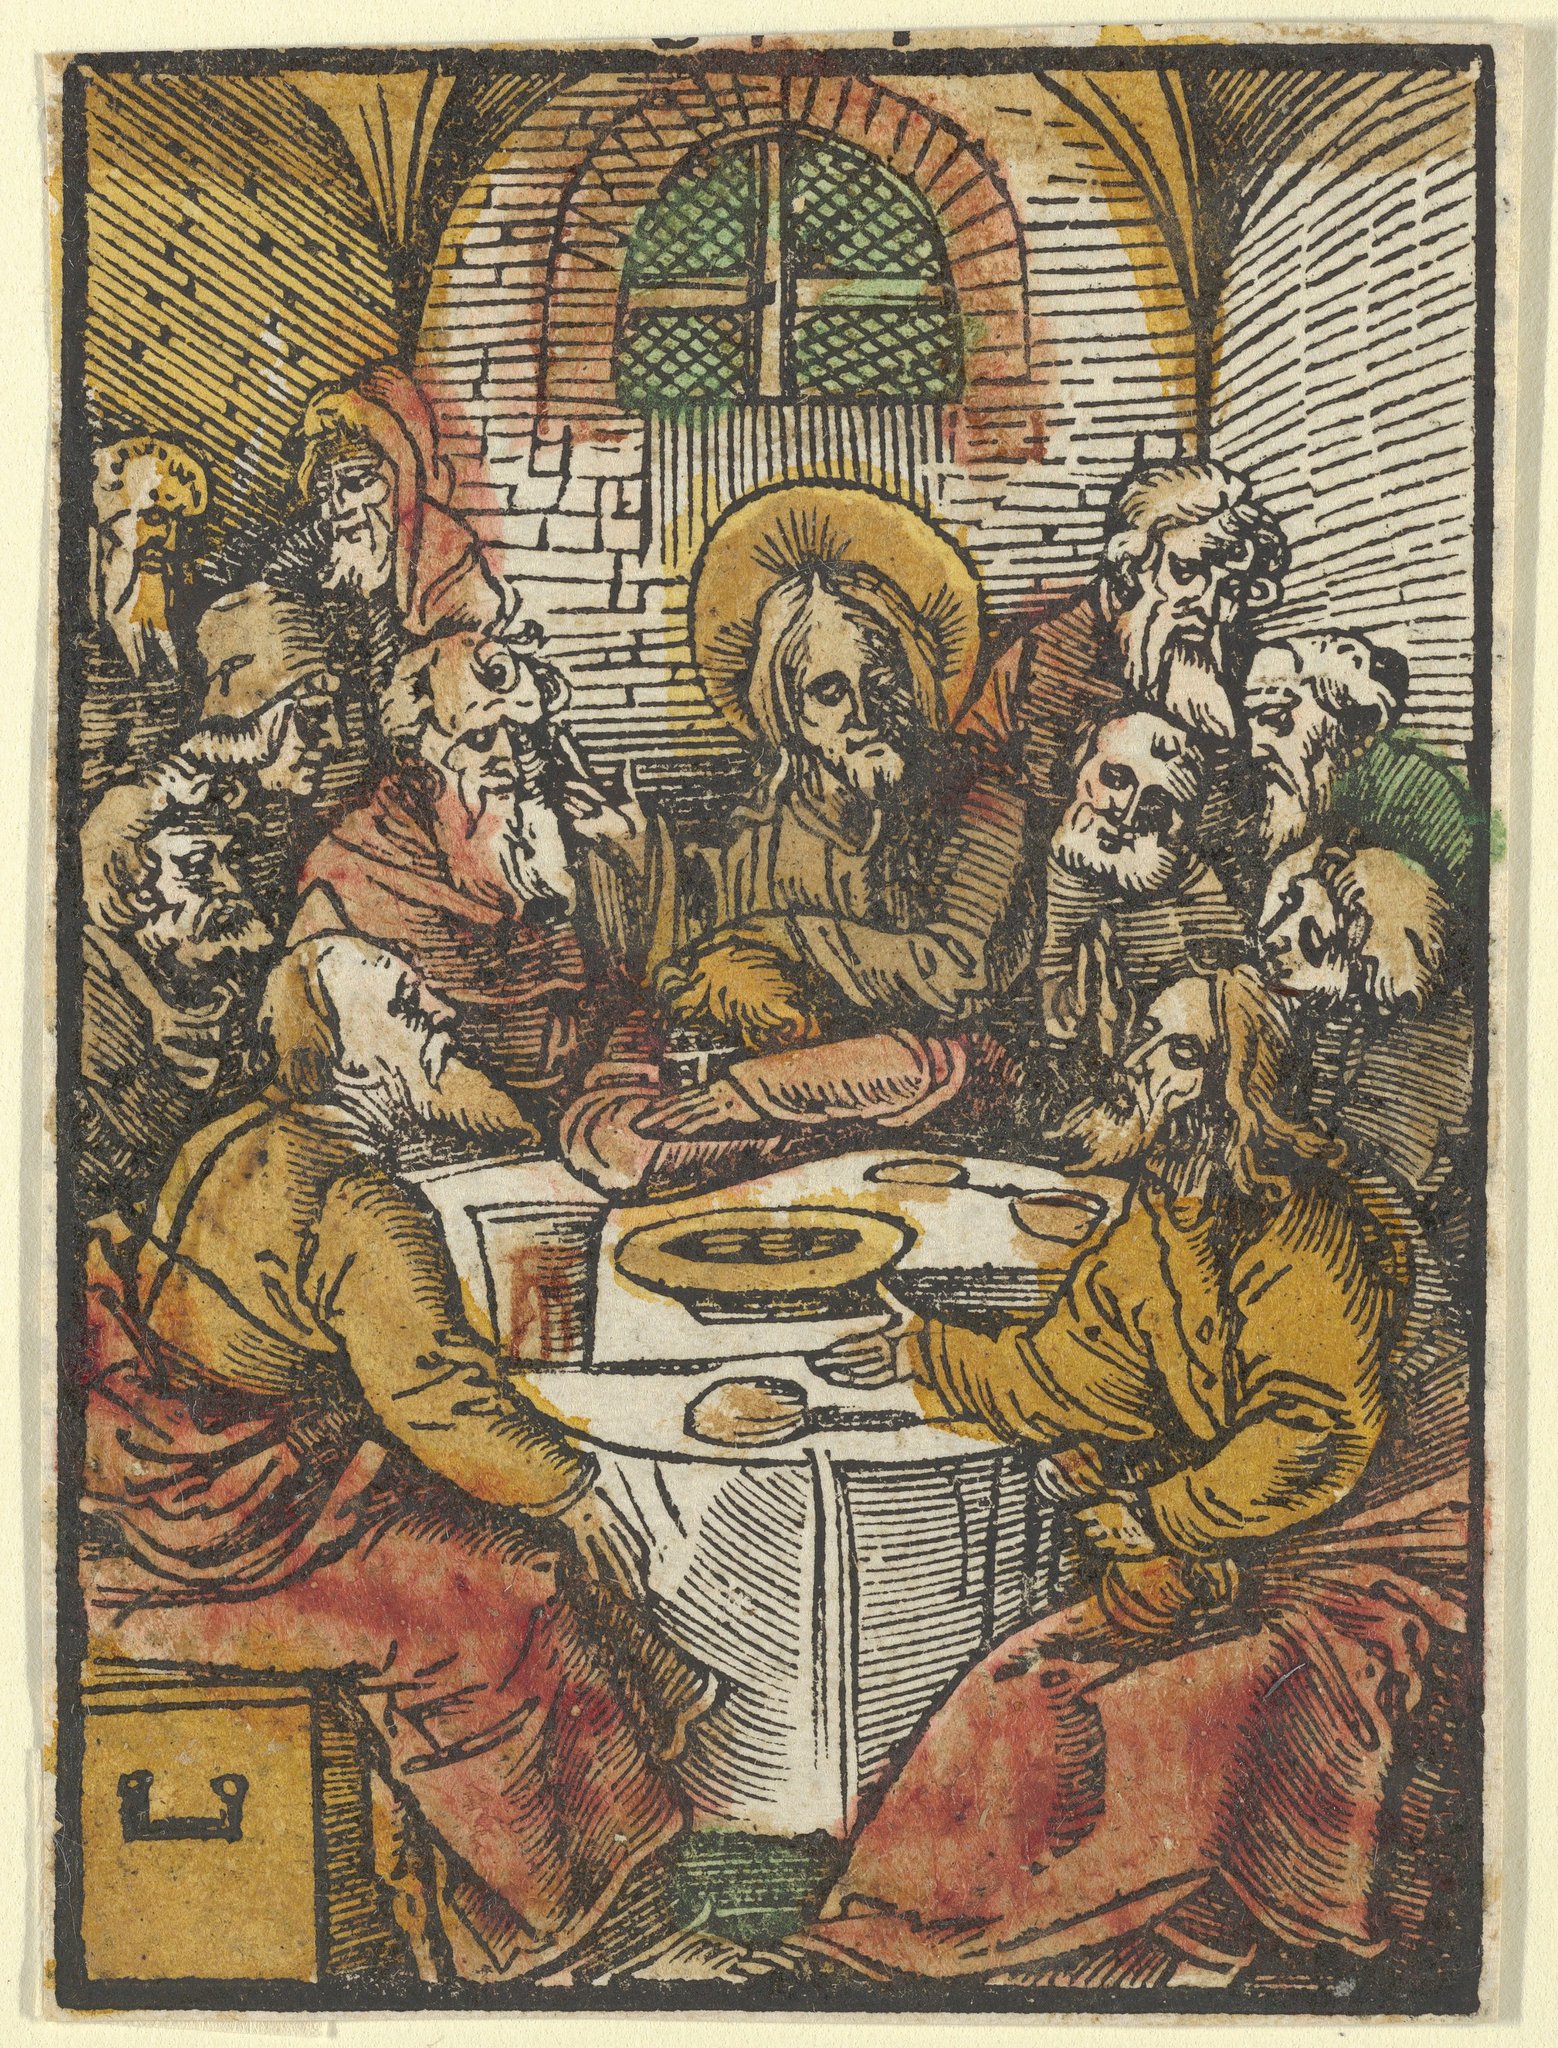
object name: print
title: The Last Supper, from Das Plenarium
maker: hans schäufelein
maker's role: artist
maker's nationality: german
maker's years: 1480-1540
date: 1517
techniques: hand coloring, woodcut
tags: apostles,jesus,last supper